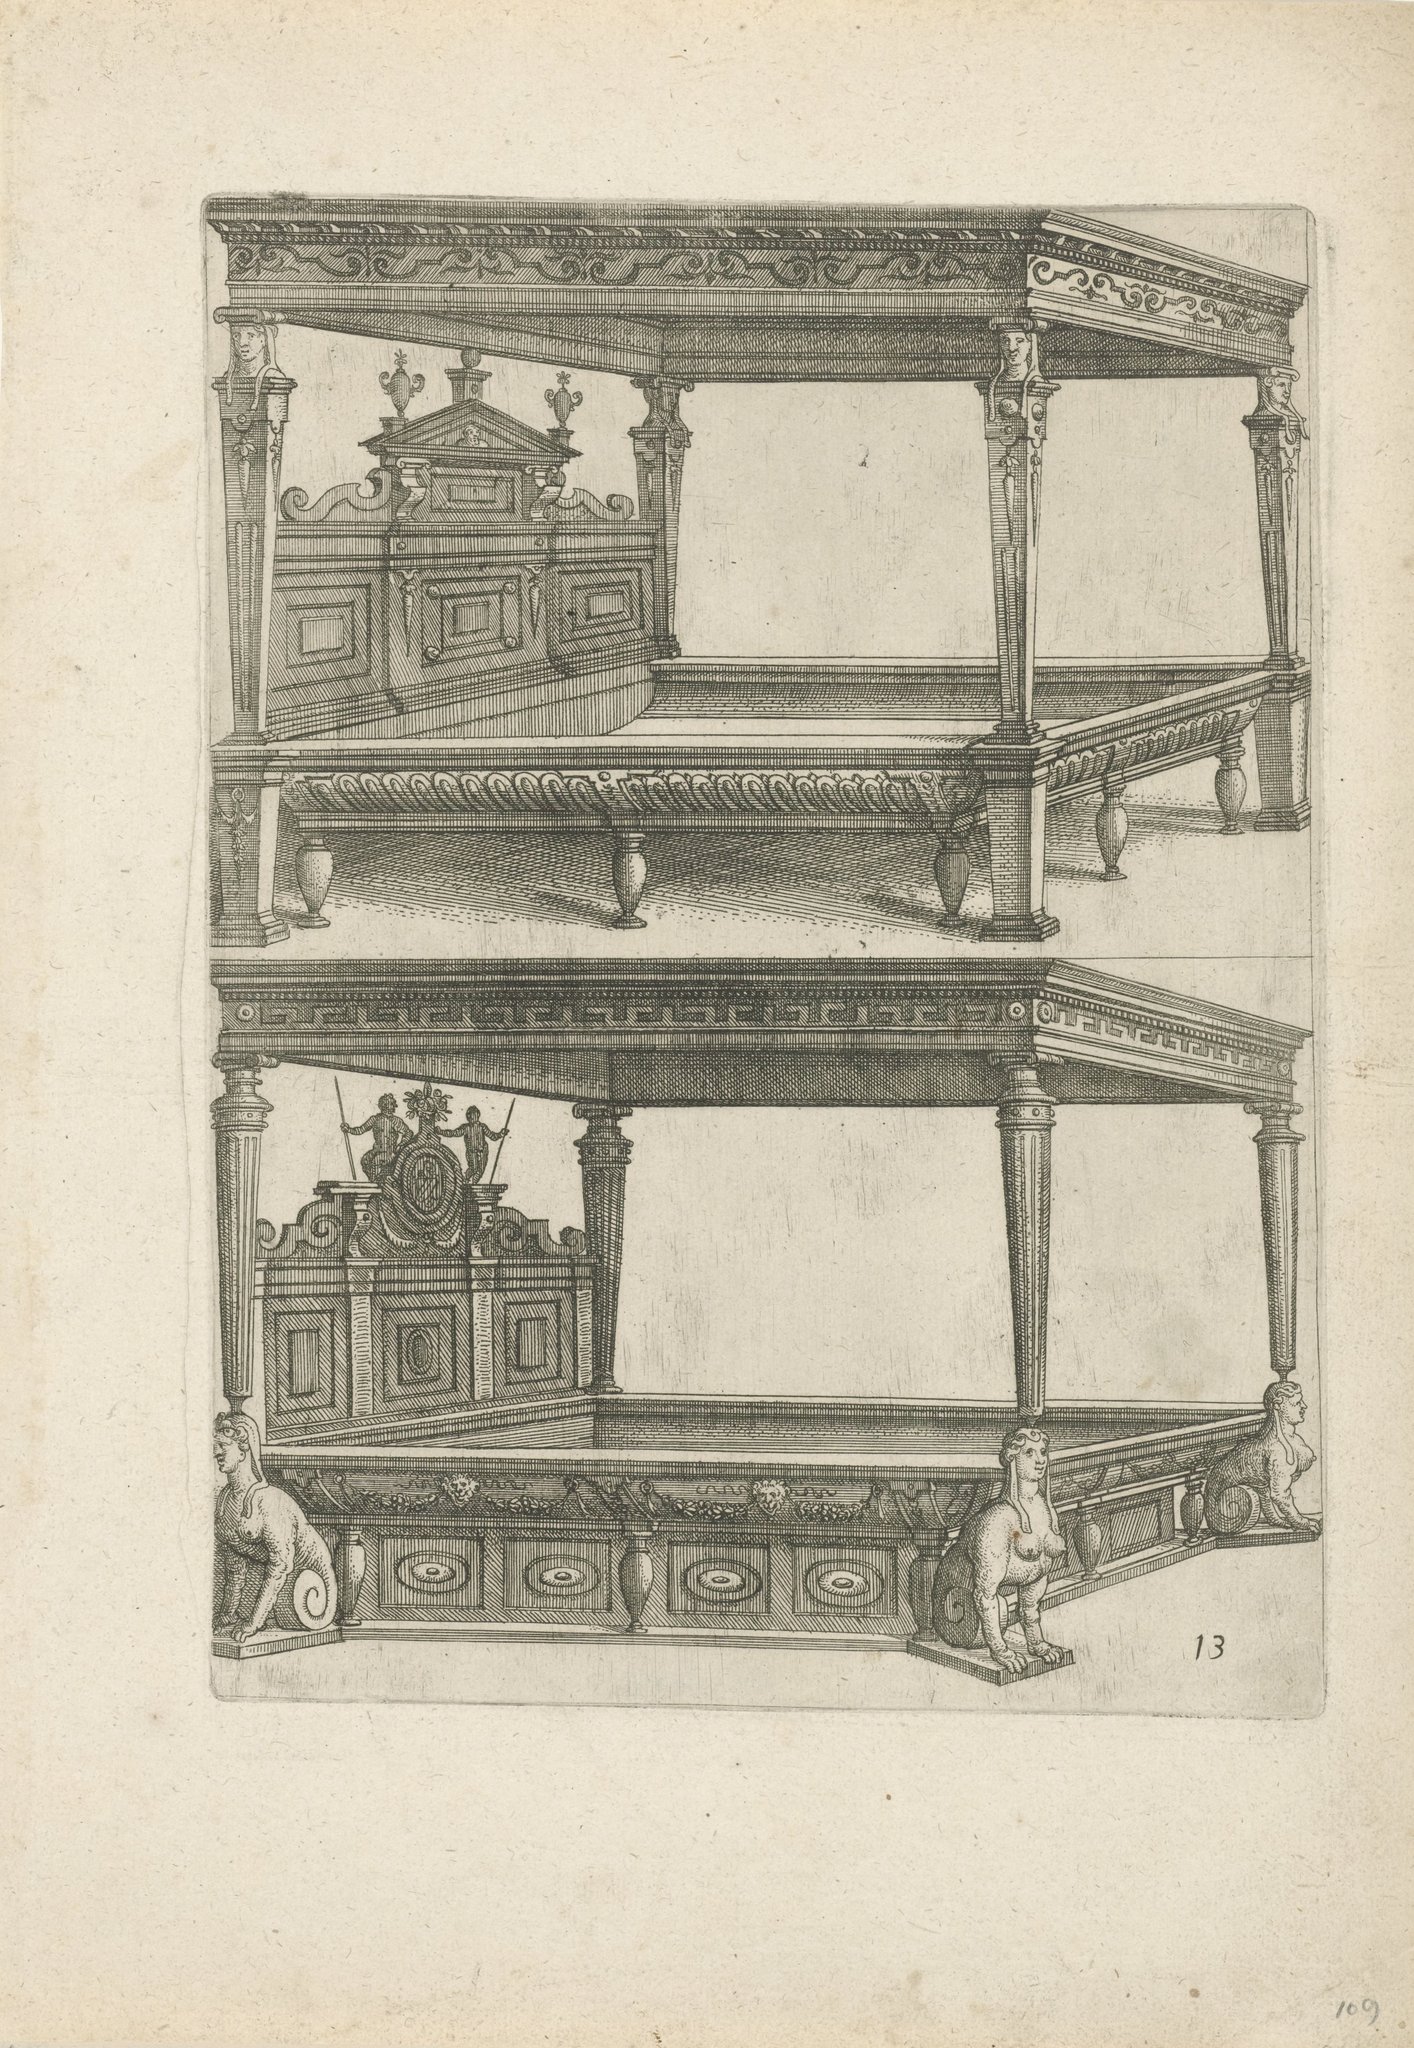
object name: ornament print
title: Twee hemelbedden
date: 1583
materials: paper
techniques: etching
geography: netherlands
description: De hemel van het bovenste bed wordt gedragen door hermen, die van het onderste bed door sterk verjongende zuilen, rustend op sfinxen. Blad 13 van 15 genummerde bladen + titelblad uit een serie van 16.